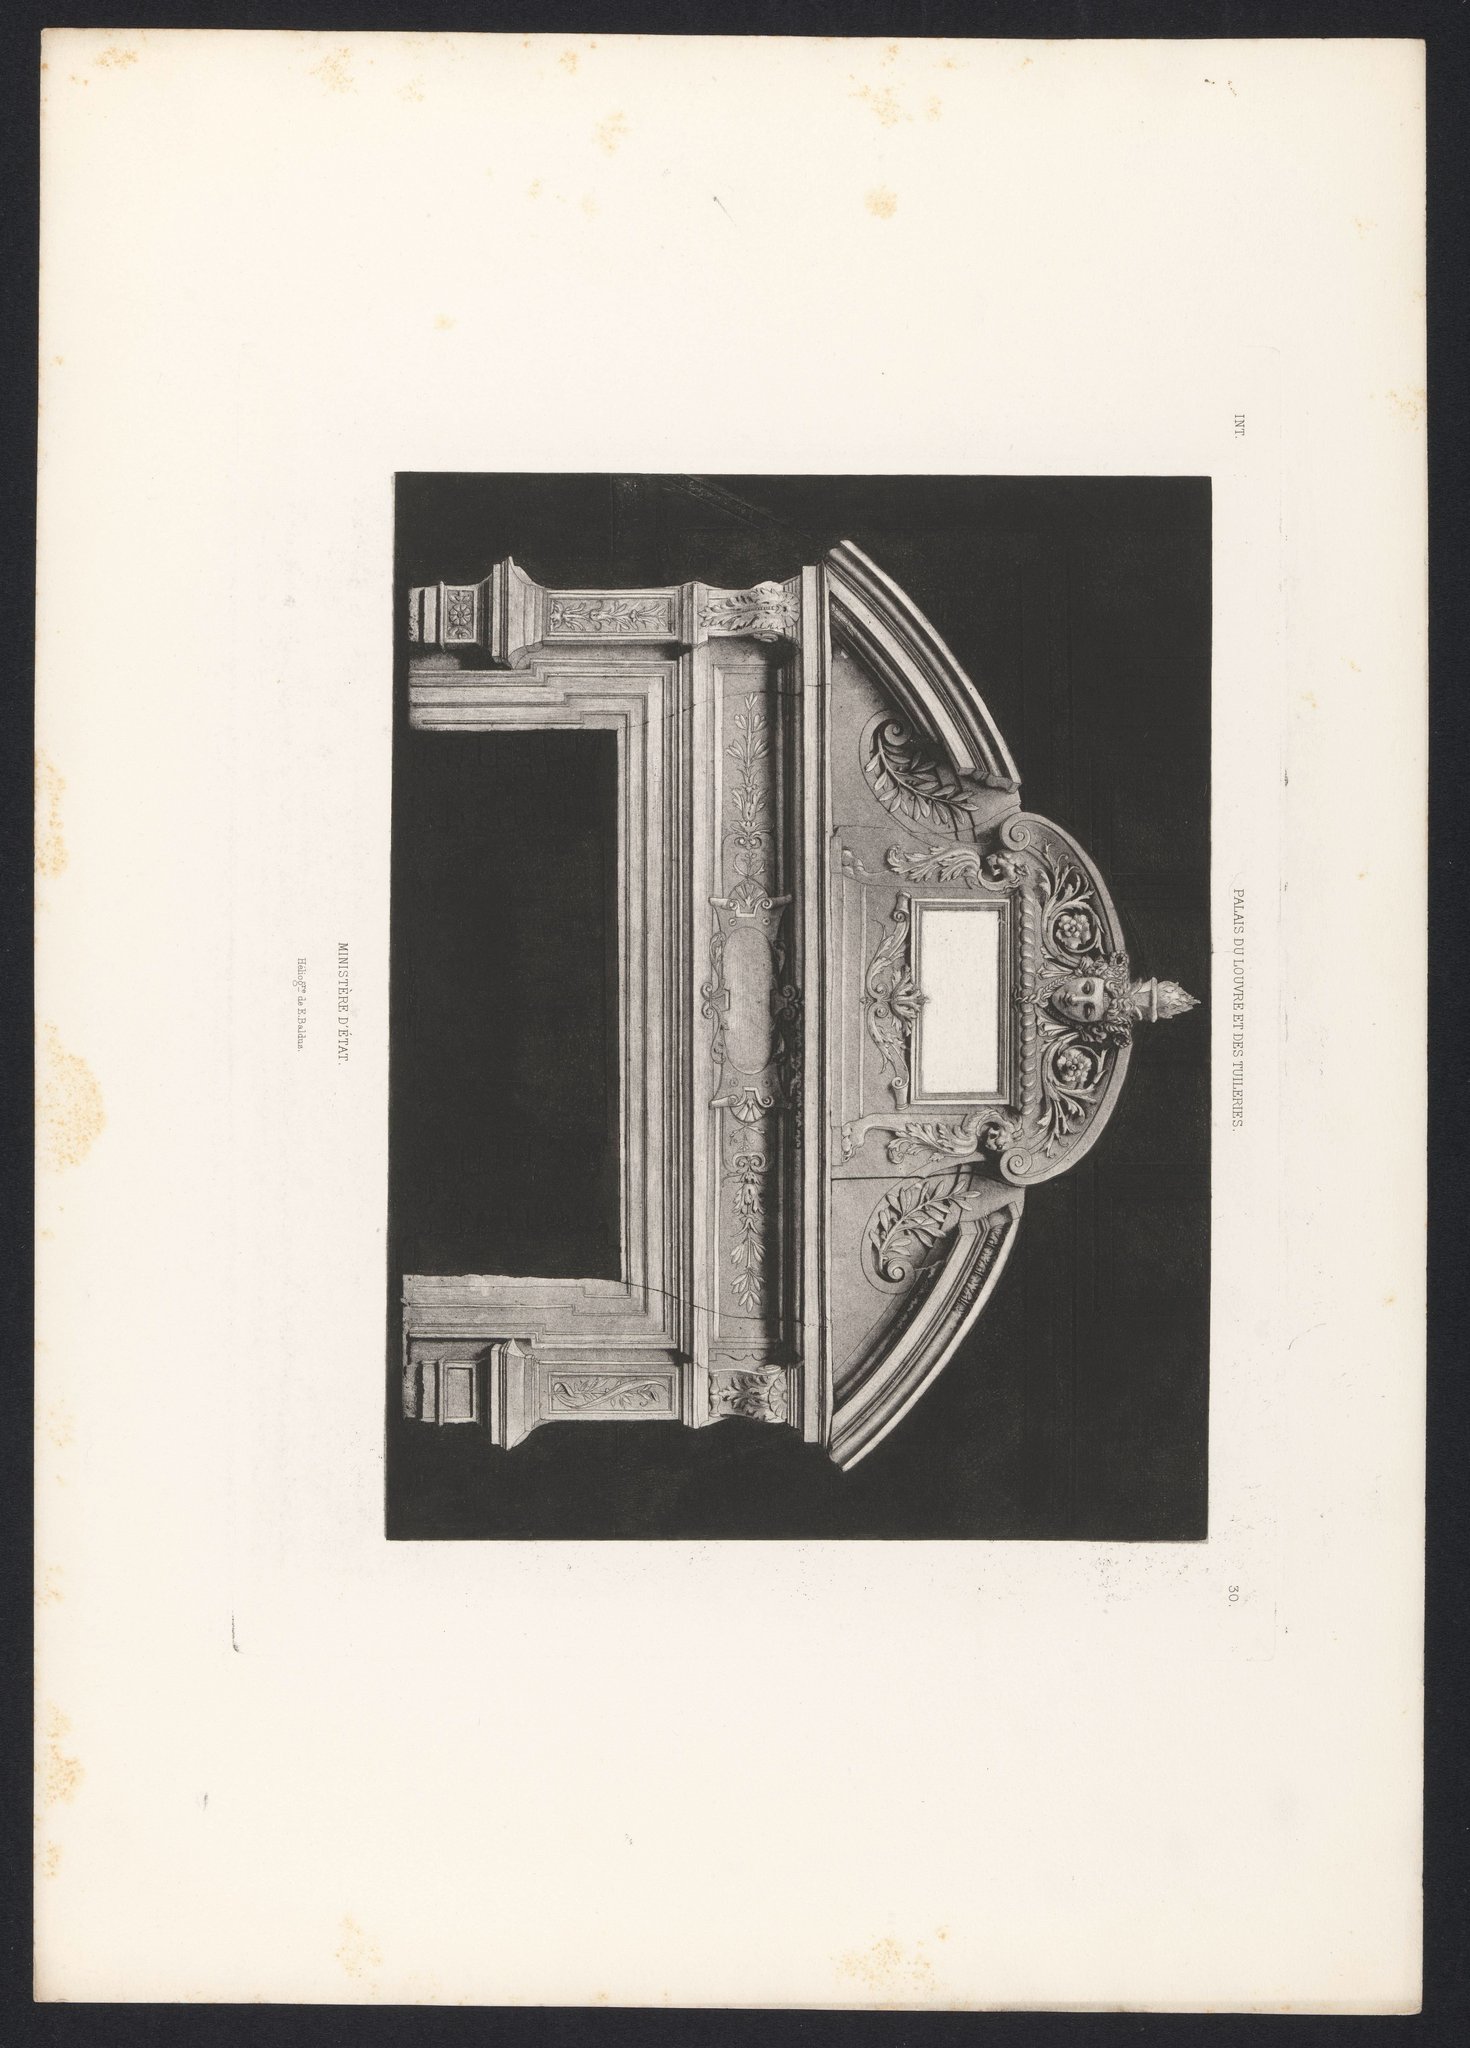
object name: page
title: Fotoreproductie van een tekening, voorstellende het tympaan van een deur (vermoedelijk) in het Palais des Tuileries te Parijs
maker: édouard denis baldus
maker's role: fotograaf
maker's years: 1813-1889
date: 1865-1870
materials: paper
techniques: photoaquatint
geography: france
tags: ornaments ~ art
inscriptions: number: ‘Int. 30’